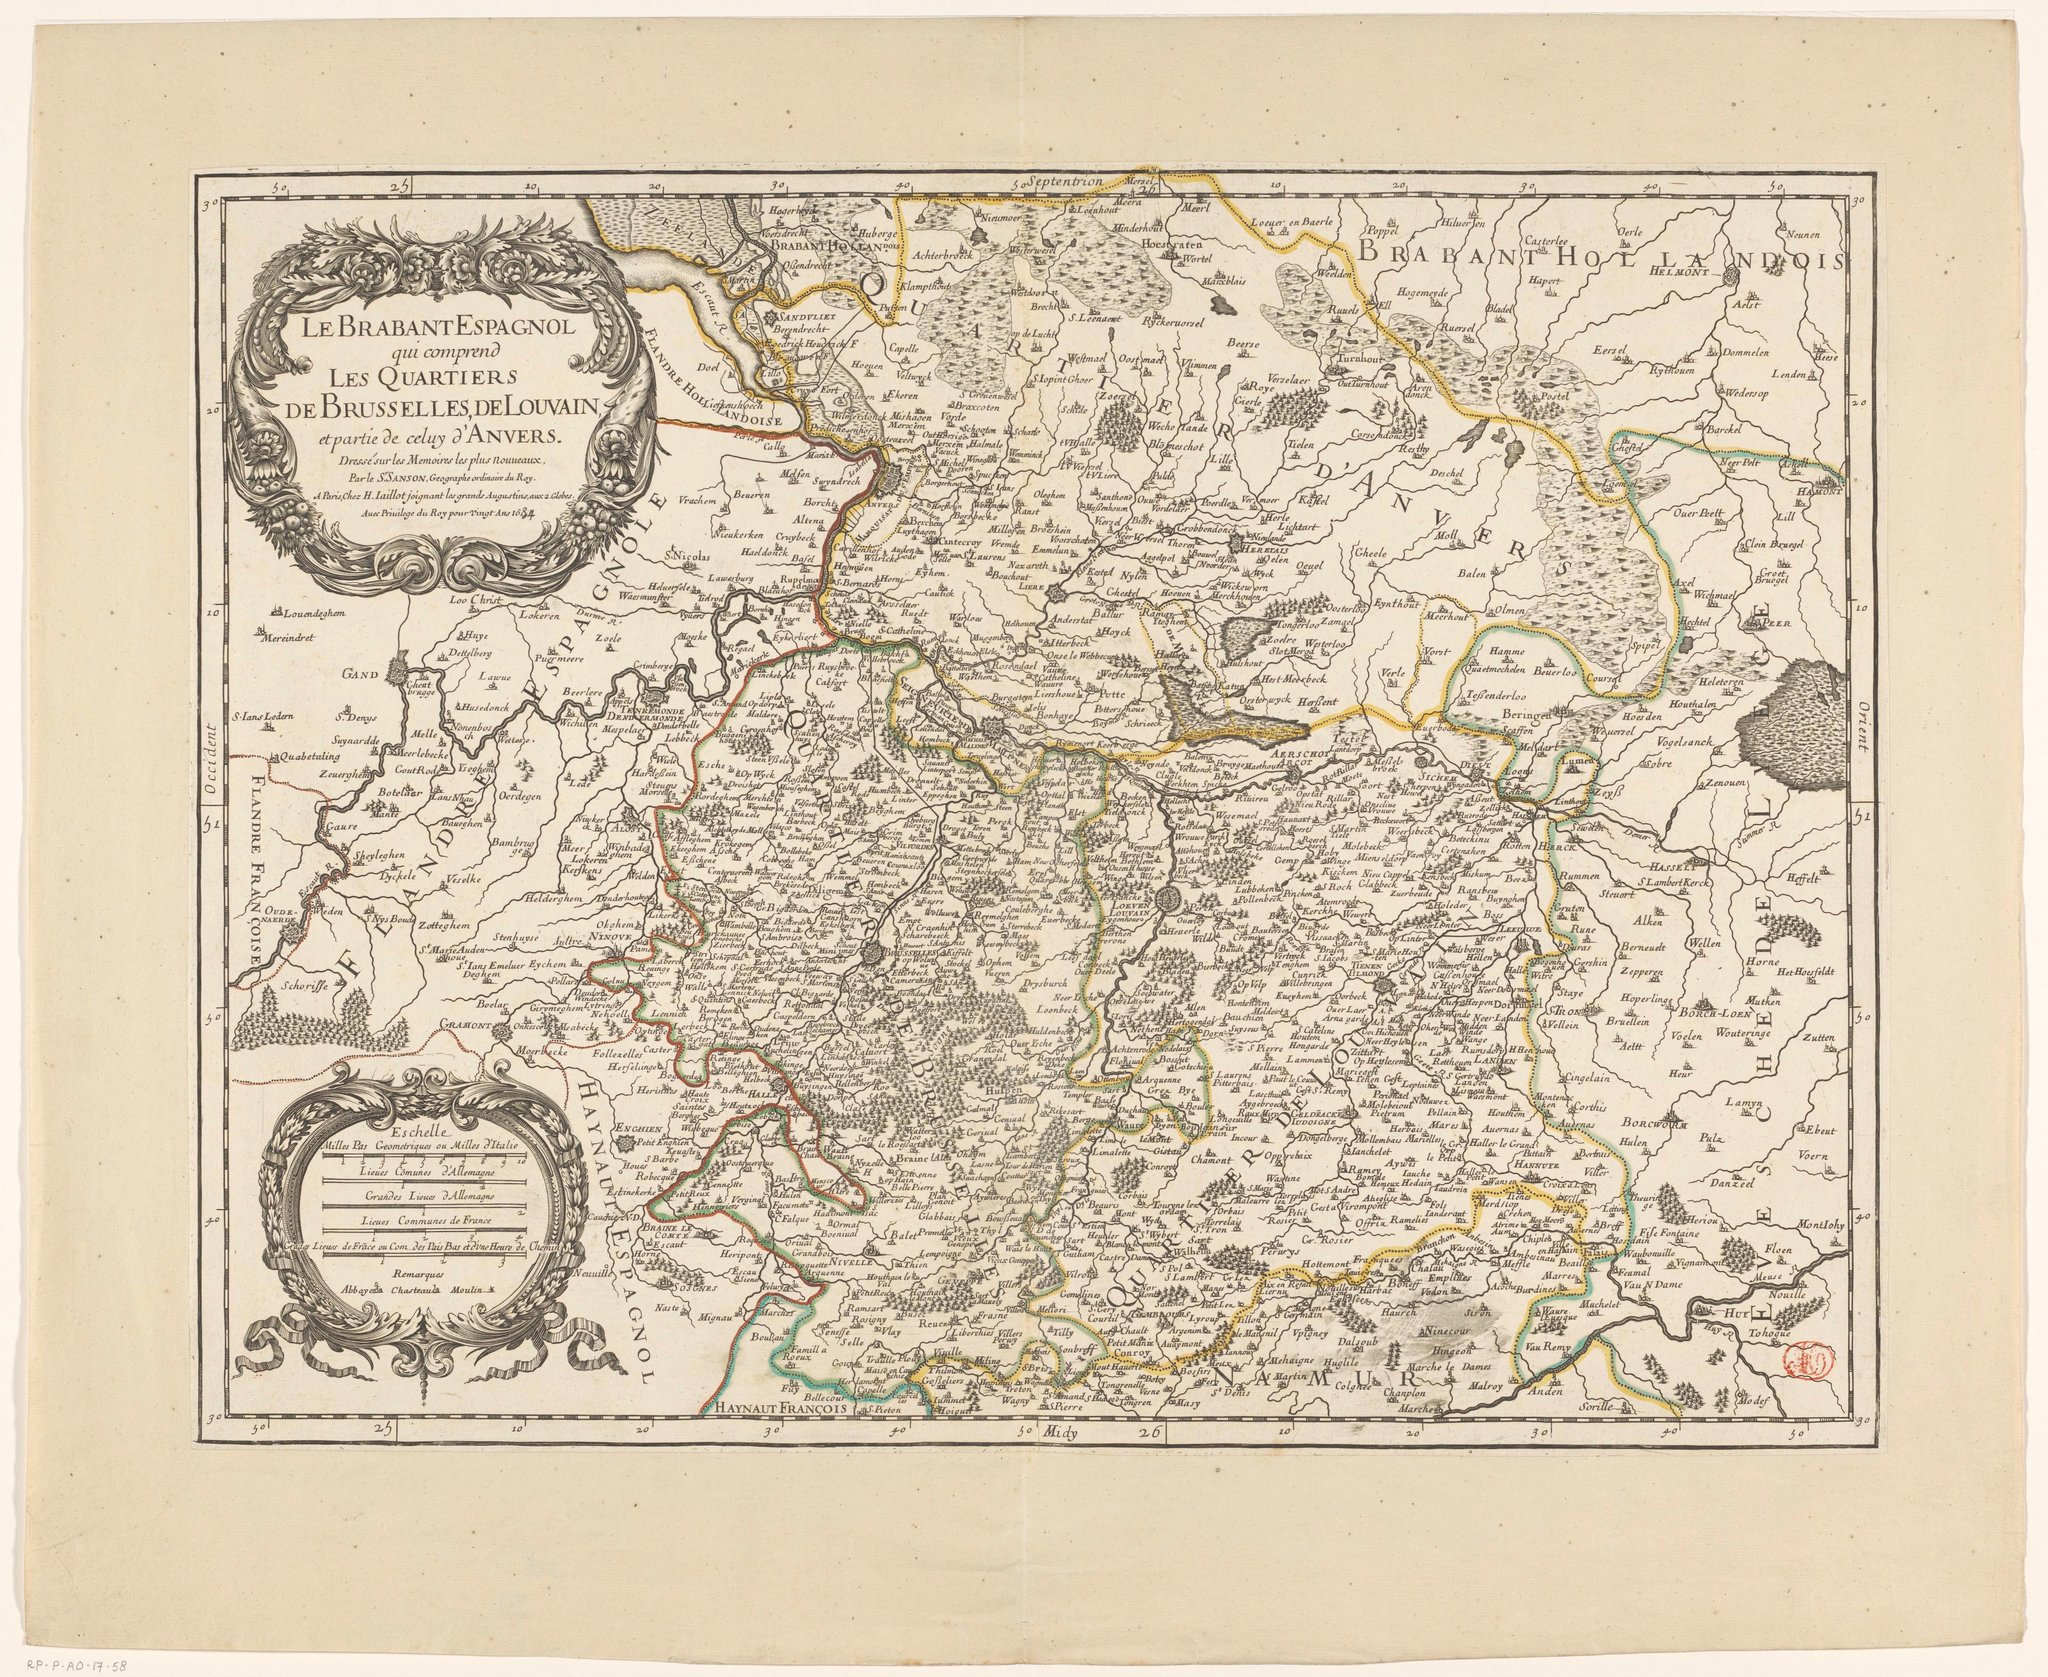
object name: print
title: Le Brabant Espagnol qui comprend les quartiers de Brusselles (...)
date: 1684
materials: paper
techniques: engraving, etching, hand coloring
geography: paris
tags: maps of separate countries or regions, brabant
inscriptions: collector's mark: Lugt 195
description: Kaart van de kwartieren van Brussel, Leuven en Antwerpen. Linksboven de titelcartouche. Linksonder een cartouche met legenda en vijf schaalstokken: 10 Milles Pas Geometriques ou Milles d'Italie / 2 Lieues Comunes d'Allemagne, en nog drie andere. De kaart is voorzien van een gradenverdeling langs de randen.